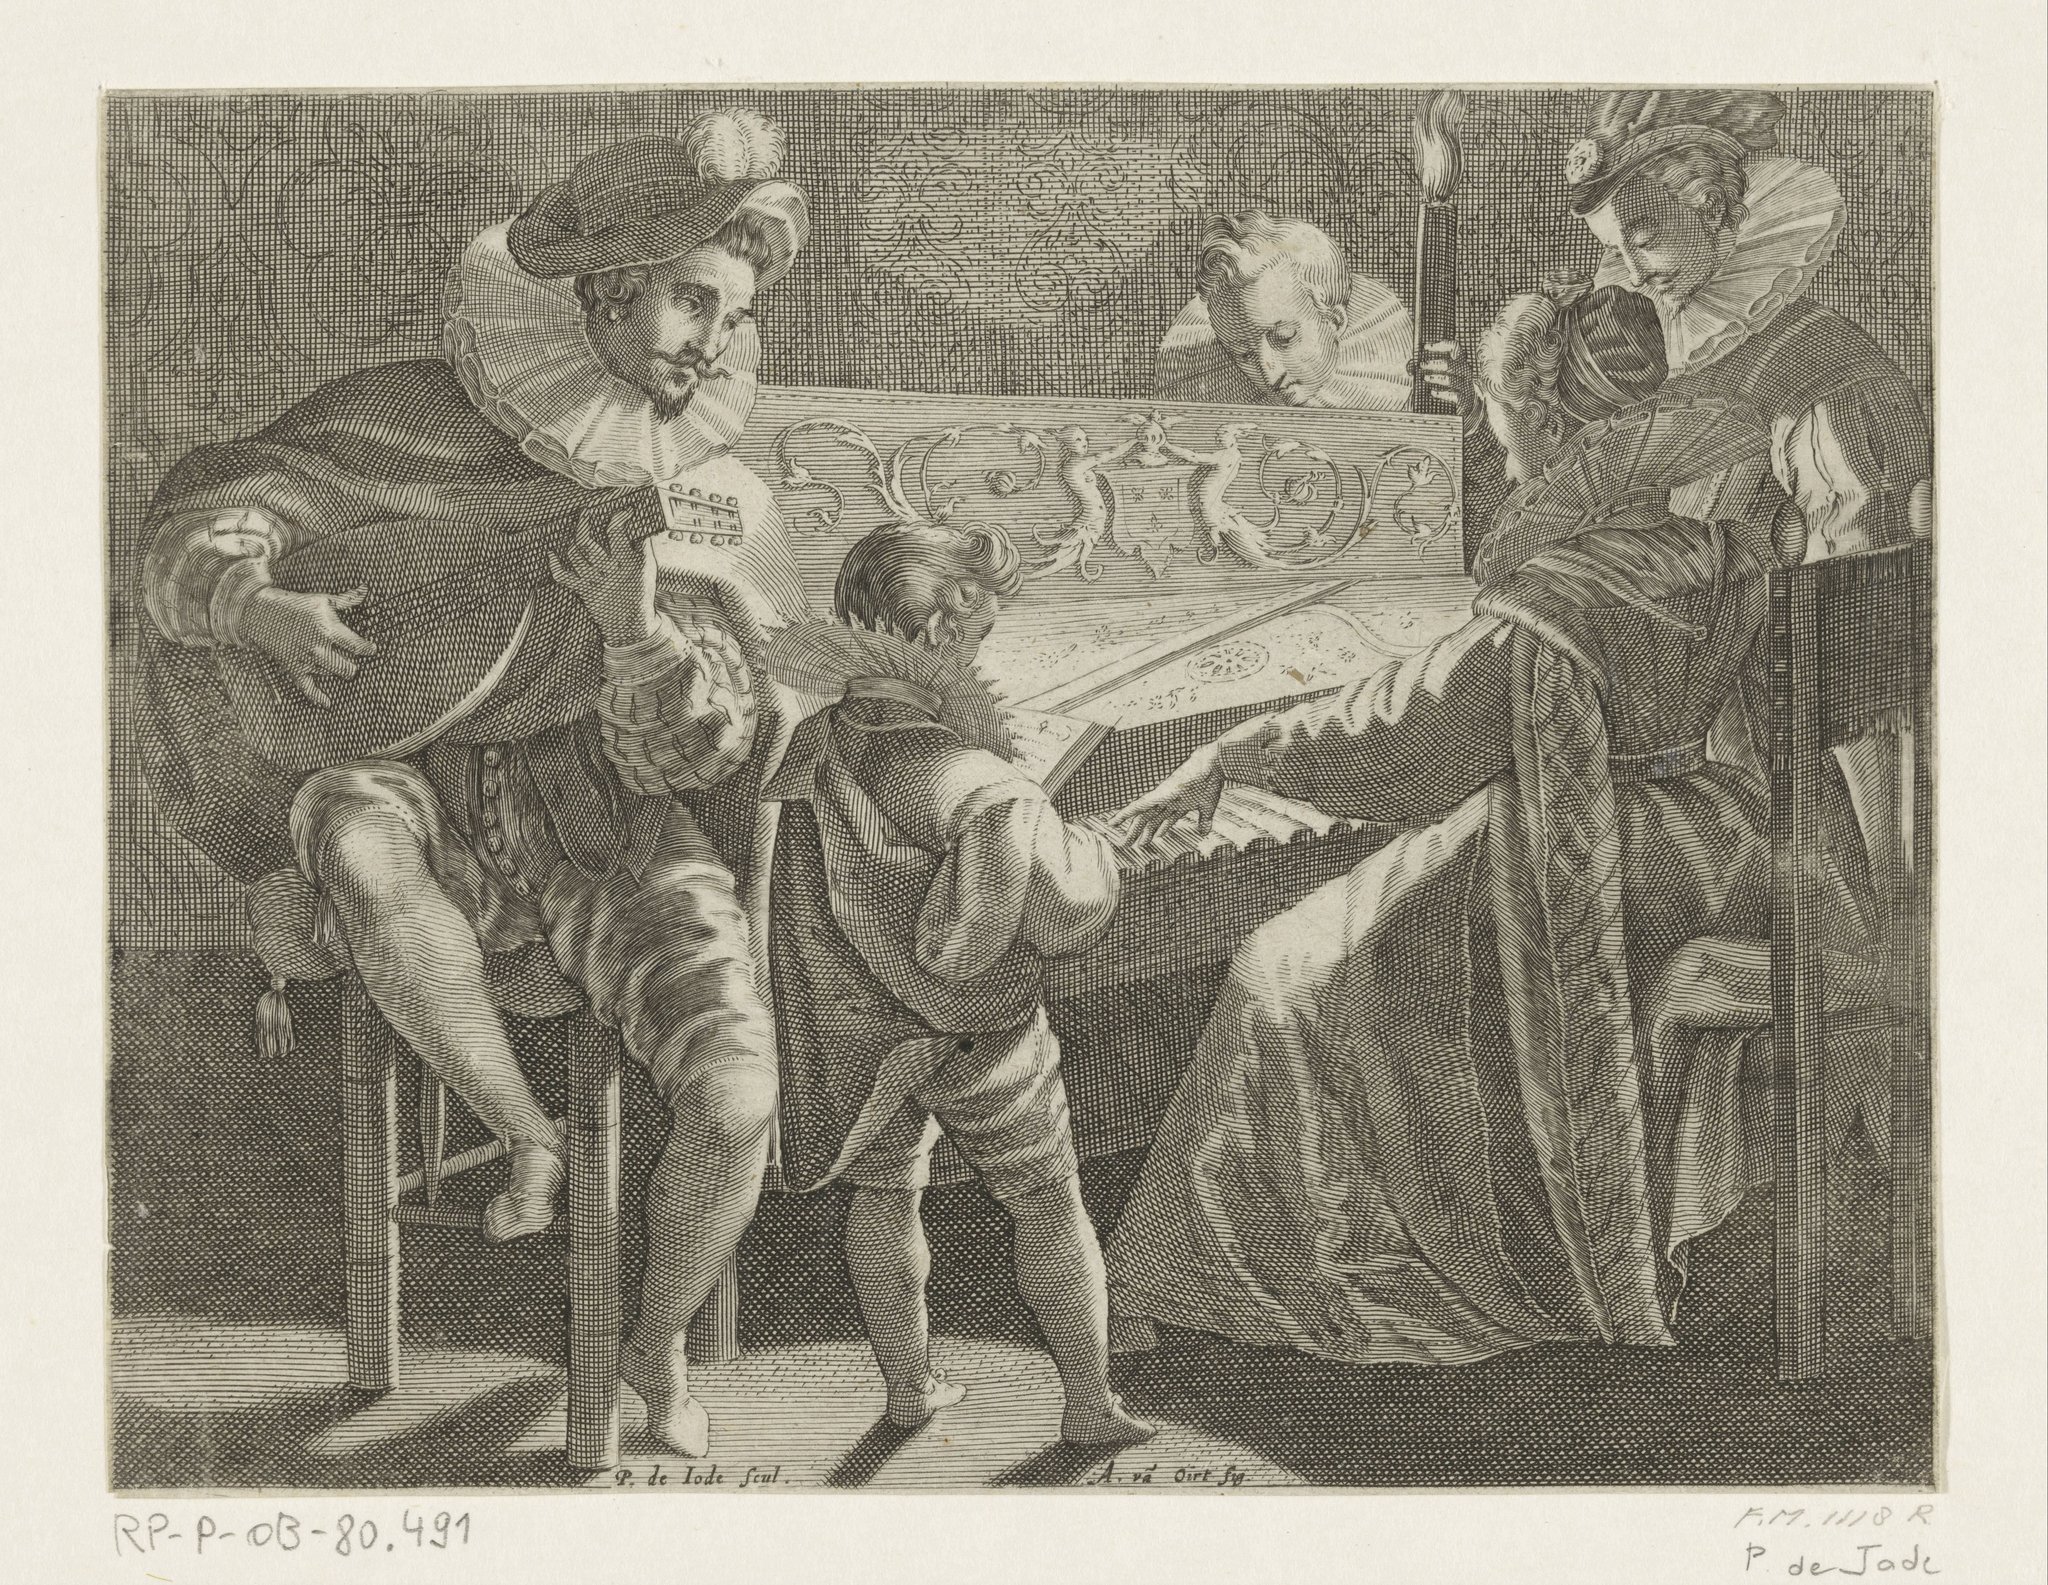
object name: print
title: Musicerend gezelschap bij toortslicht, ca. 1600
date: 1594-1595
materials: paper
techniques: engraving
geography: southern netherlands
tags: instrumental and vocal music together, spinet, virginal, low countries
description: Musicerend gezelschap met toortslicht, ca. 1600. Interieur met een vrouw spelend op de virginaal, een man begeleidt haar op de luit en een jongen zingt.